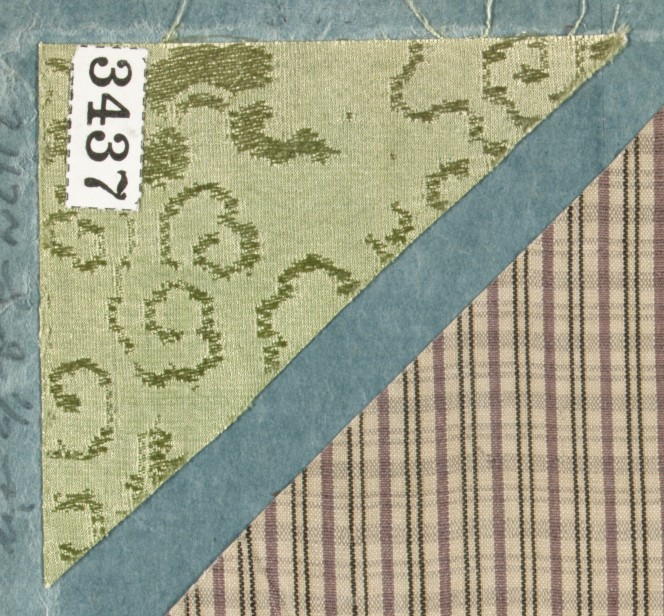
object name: textile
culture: japanese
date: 1801-1900